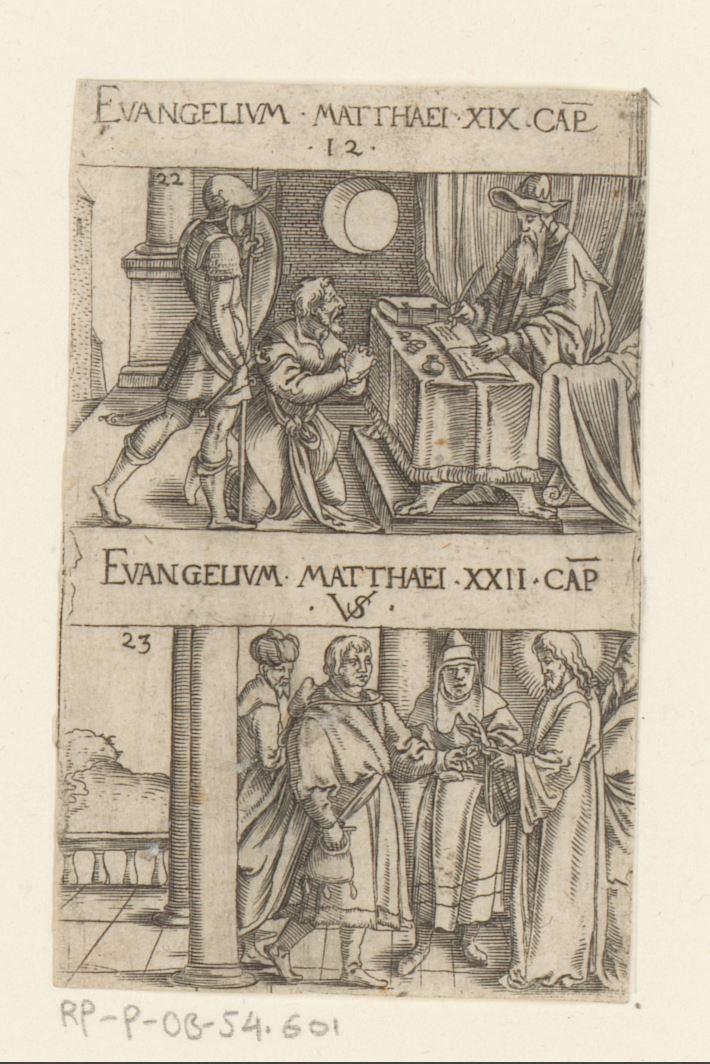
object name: print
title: Parabel van de ondankbare dienstknecht en Christus in debat met farizeeën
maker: virgilius solis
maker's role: draughtsman, print maker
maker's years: 1514-1562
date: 1524-1562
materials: paper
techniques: engraving, etching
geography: nuremberg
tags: the unmerciful servant: the king forgives him his debts ~ parable of christ (matthew 18:23-35), christ (in the temple) in debate with pharisees about the tribute to caesar (matthew 22:15-22; mark 12:13-17; luke 20:20-26)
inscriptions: number: ‘88’, collector's mark: Lugt 2228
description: Deze prent maakt deel uit van een serie bestaande uit 27 genummerde prenten. De prenten tonen steeds twee evangelische scènes boven elkaar. Alle voorstellingen behalve de bovenste van de eerste prent zijn eveneens afzonderlijk genummerd.